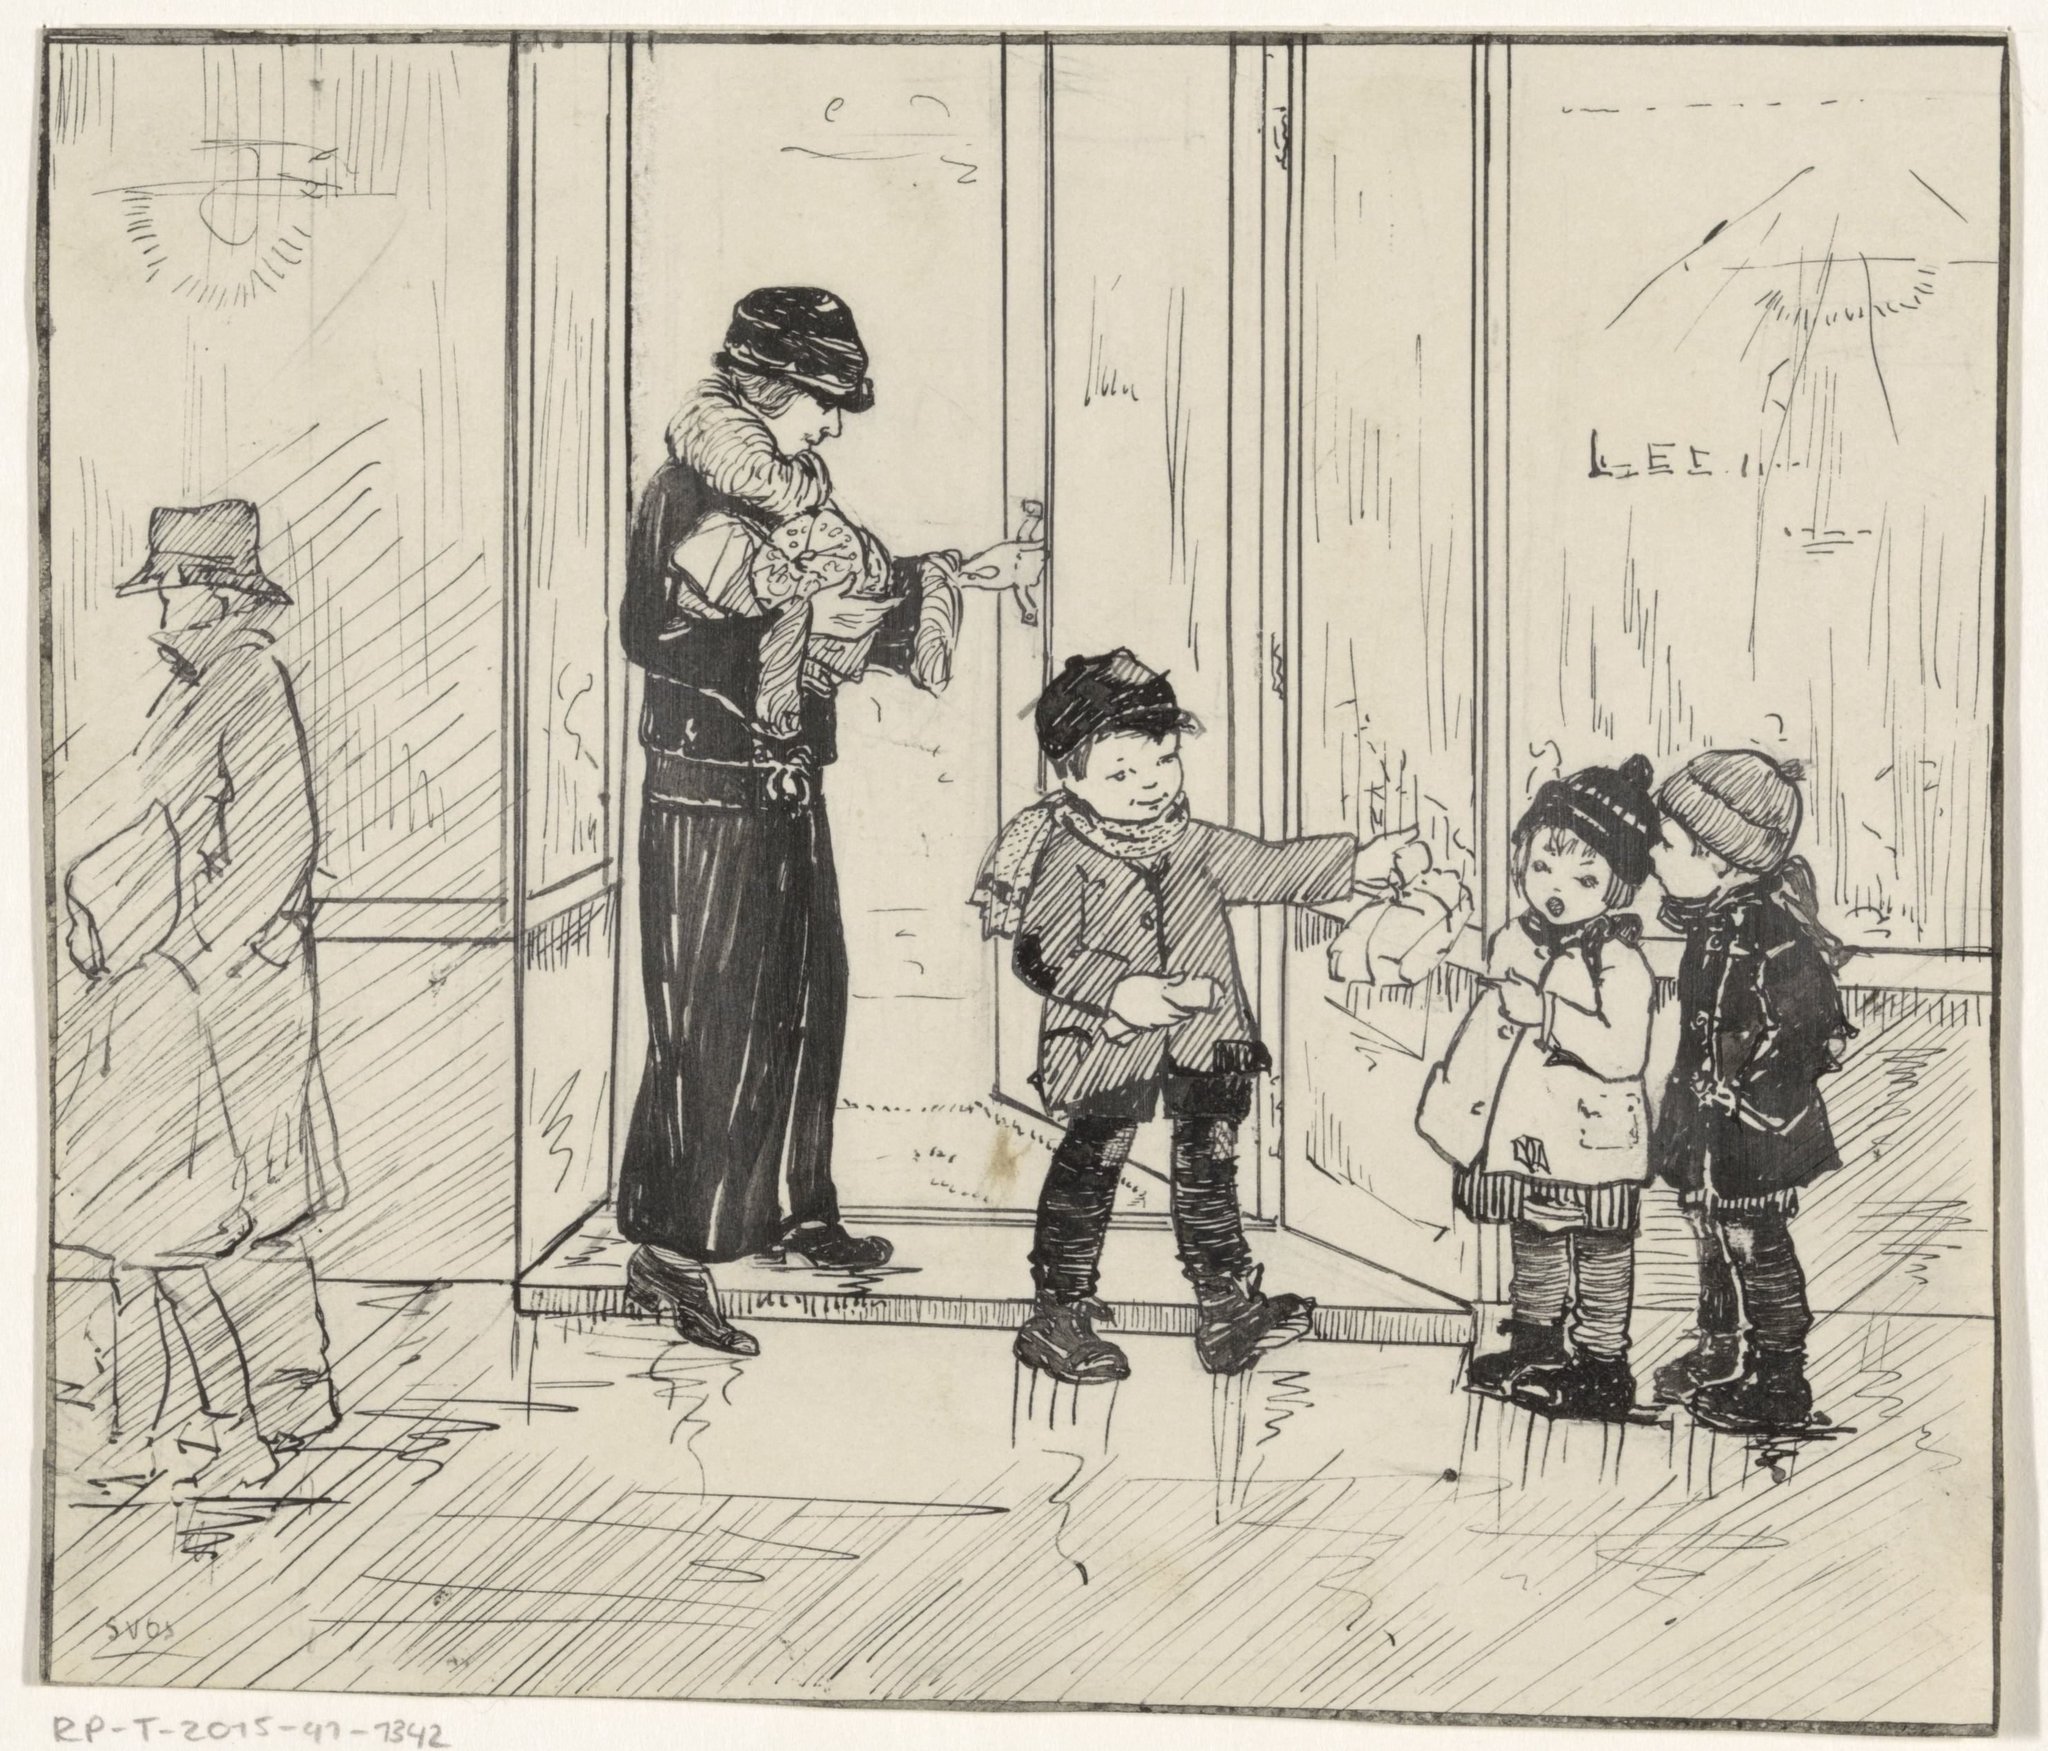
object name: drawing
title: Jongen en moeder verlaten een winkel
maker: s. van os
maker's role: draughtsman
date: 1900-1940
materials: ink, paper, pencil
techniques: brush, pen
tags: mother and son(s) (family group), shop, store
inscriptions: signature: ‘SvOs’, collector's mark: Lugt 2228, annotation: ‘En met leege handjes of/ mondjes kwam geen/ er weer uit!’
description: Een jongen en moeder verlaten een winkel. De moeder draagt een aantal pakketten op de arm. De jongen draagt een pakket waar twee kinderen die bij de winkeletalage staan naar kijken en wijzen.